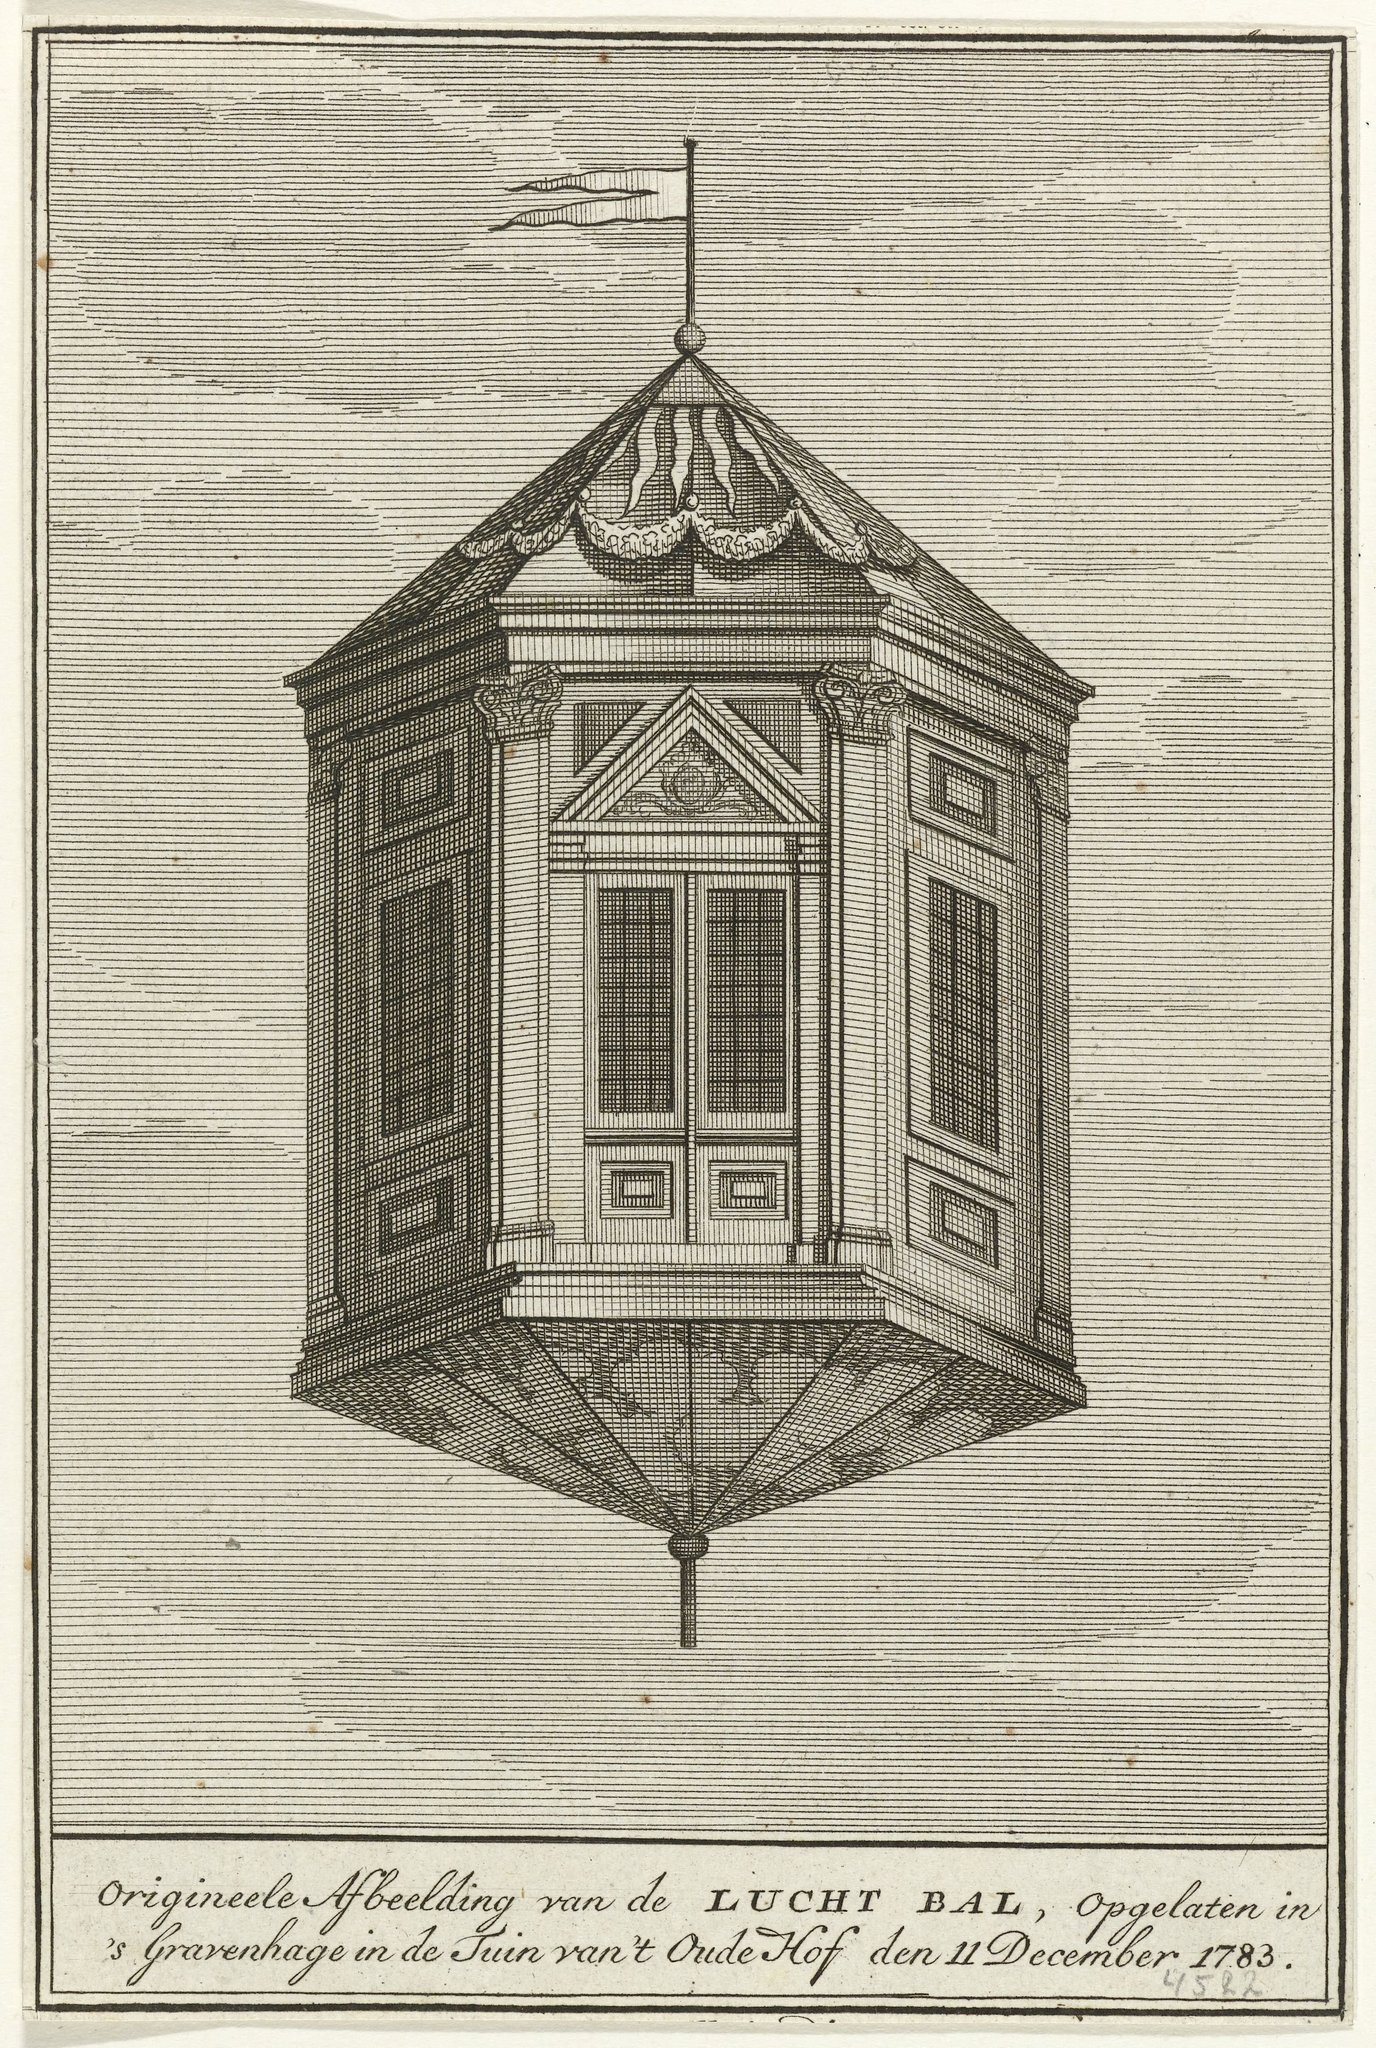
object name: print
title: Origineele Afbeelding van de Lucht Bal, Opgelaten in 's Gravenhage in de Tuin van 't Oude Hof den 11 December 1783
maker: Anonymous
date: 1783-1784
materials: paper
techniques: etching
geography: northern netherlands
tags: balloon (aviation), the hague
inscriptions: collector's mark: Lugt 2228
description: Gebruikt als illustratie in: Maandelijkse Nederlandsche Mercurius, december 1783.